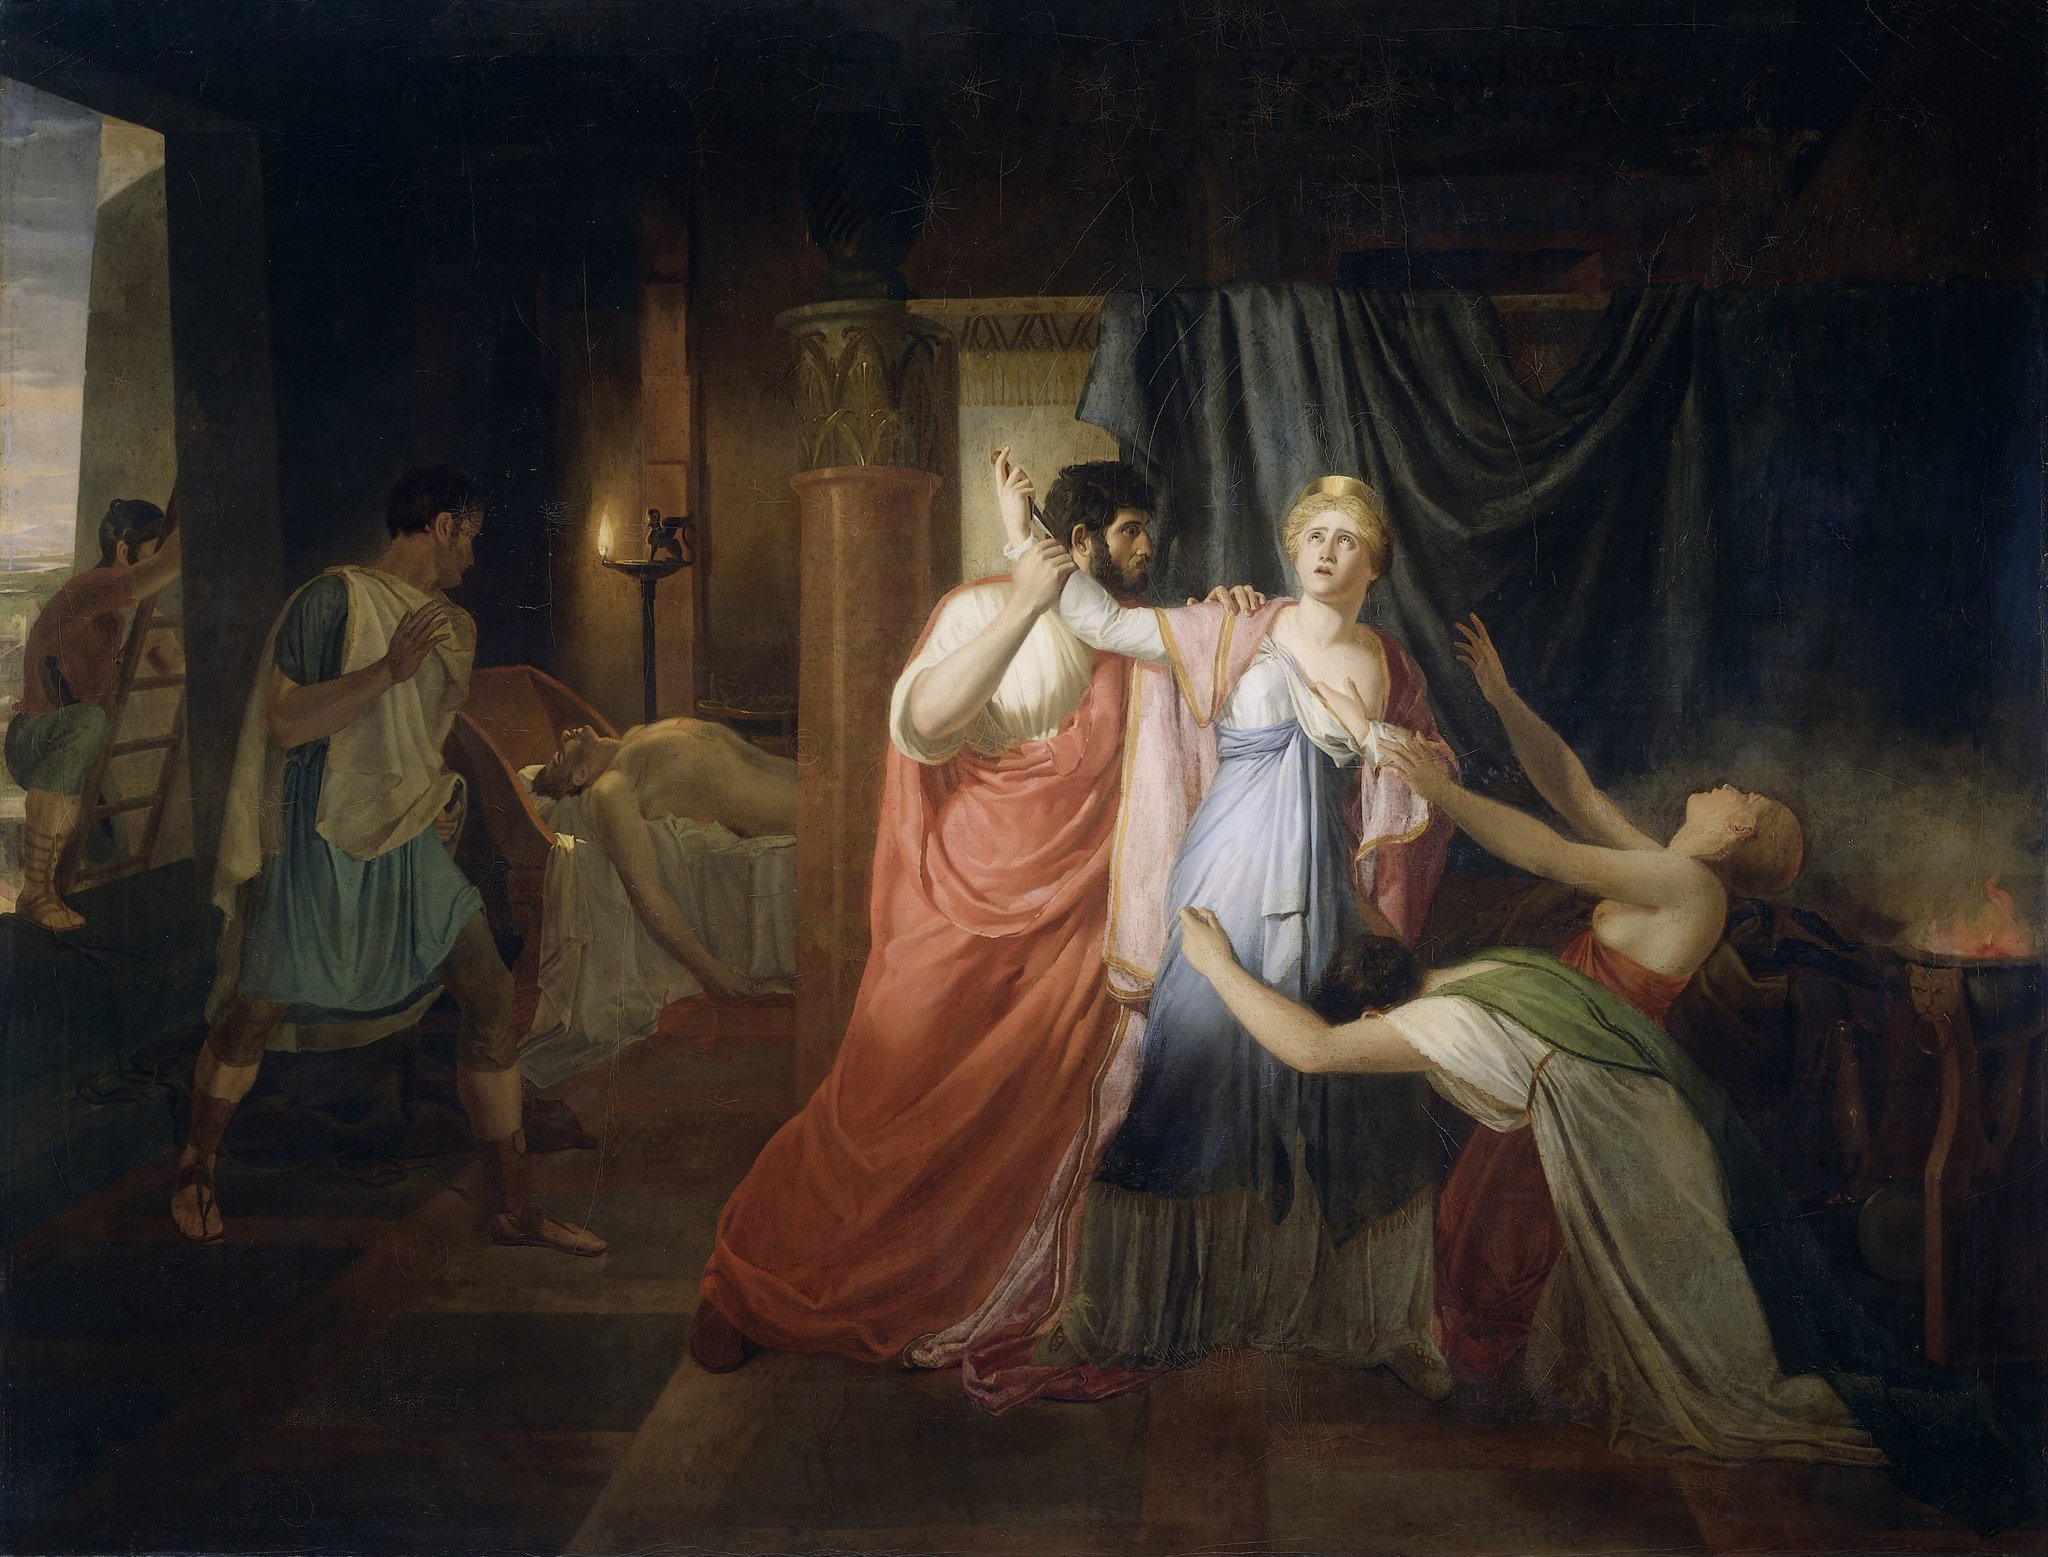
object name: painting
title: Proculeius Preventing Cleopatra from Stabbing herself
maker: joannes echarius carolus alberti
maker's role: draughtsman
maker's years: 1777-1850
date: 1810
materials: canvas, oil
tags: death of mark antony: he dies after having stabbed himself: cleopatra grieves at his bedside, suffering, misfortune of cleopatra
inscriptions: signature and date: ‘J. Alberti Roma 1810’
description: Interieur van een Egyptisch paleis. Cleopatra wil na het vinden van het dode lichaam van Antonius ook zelfmoord plegen maar wordt hiervan weerhouden door Proculeius.